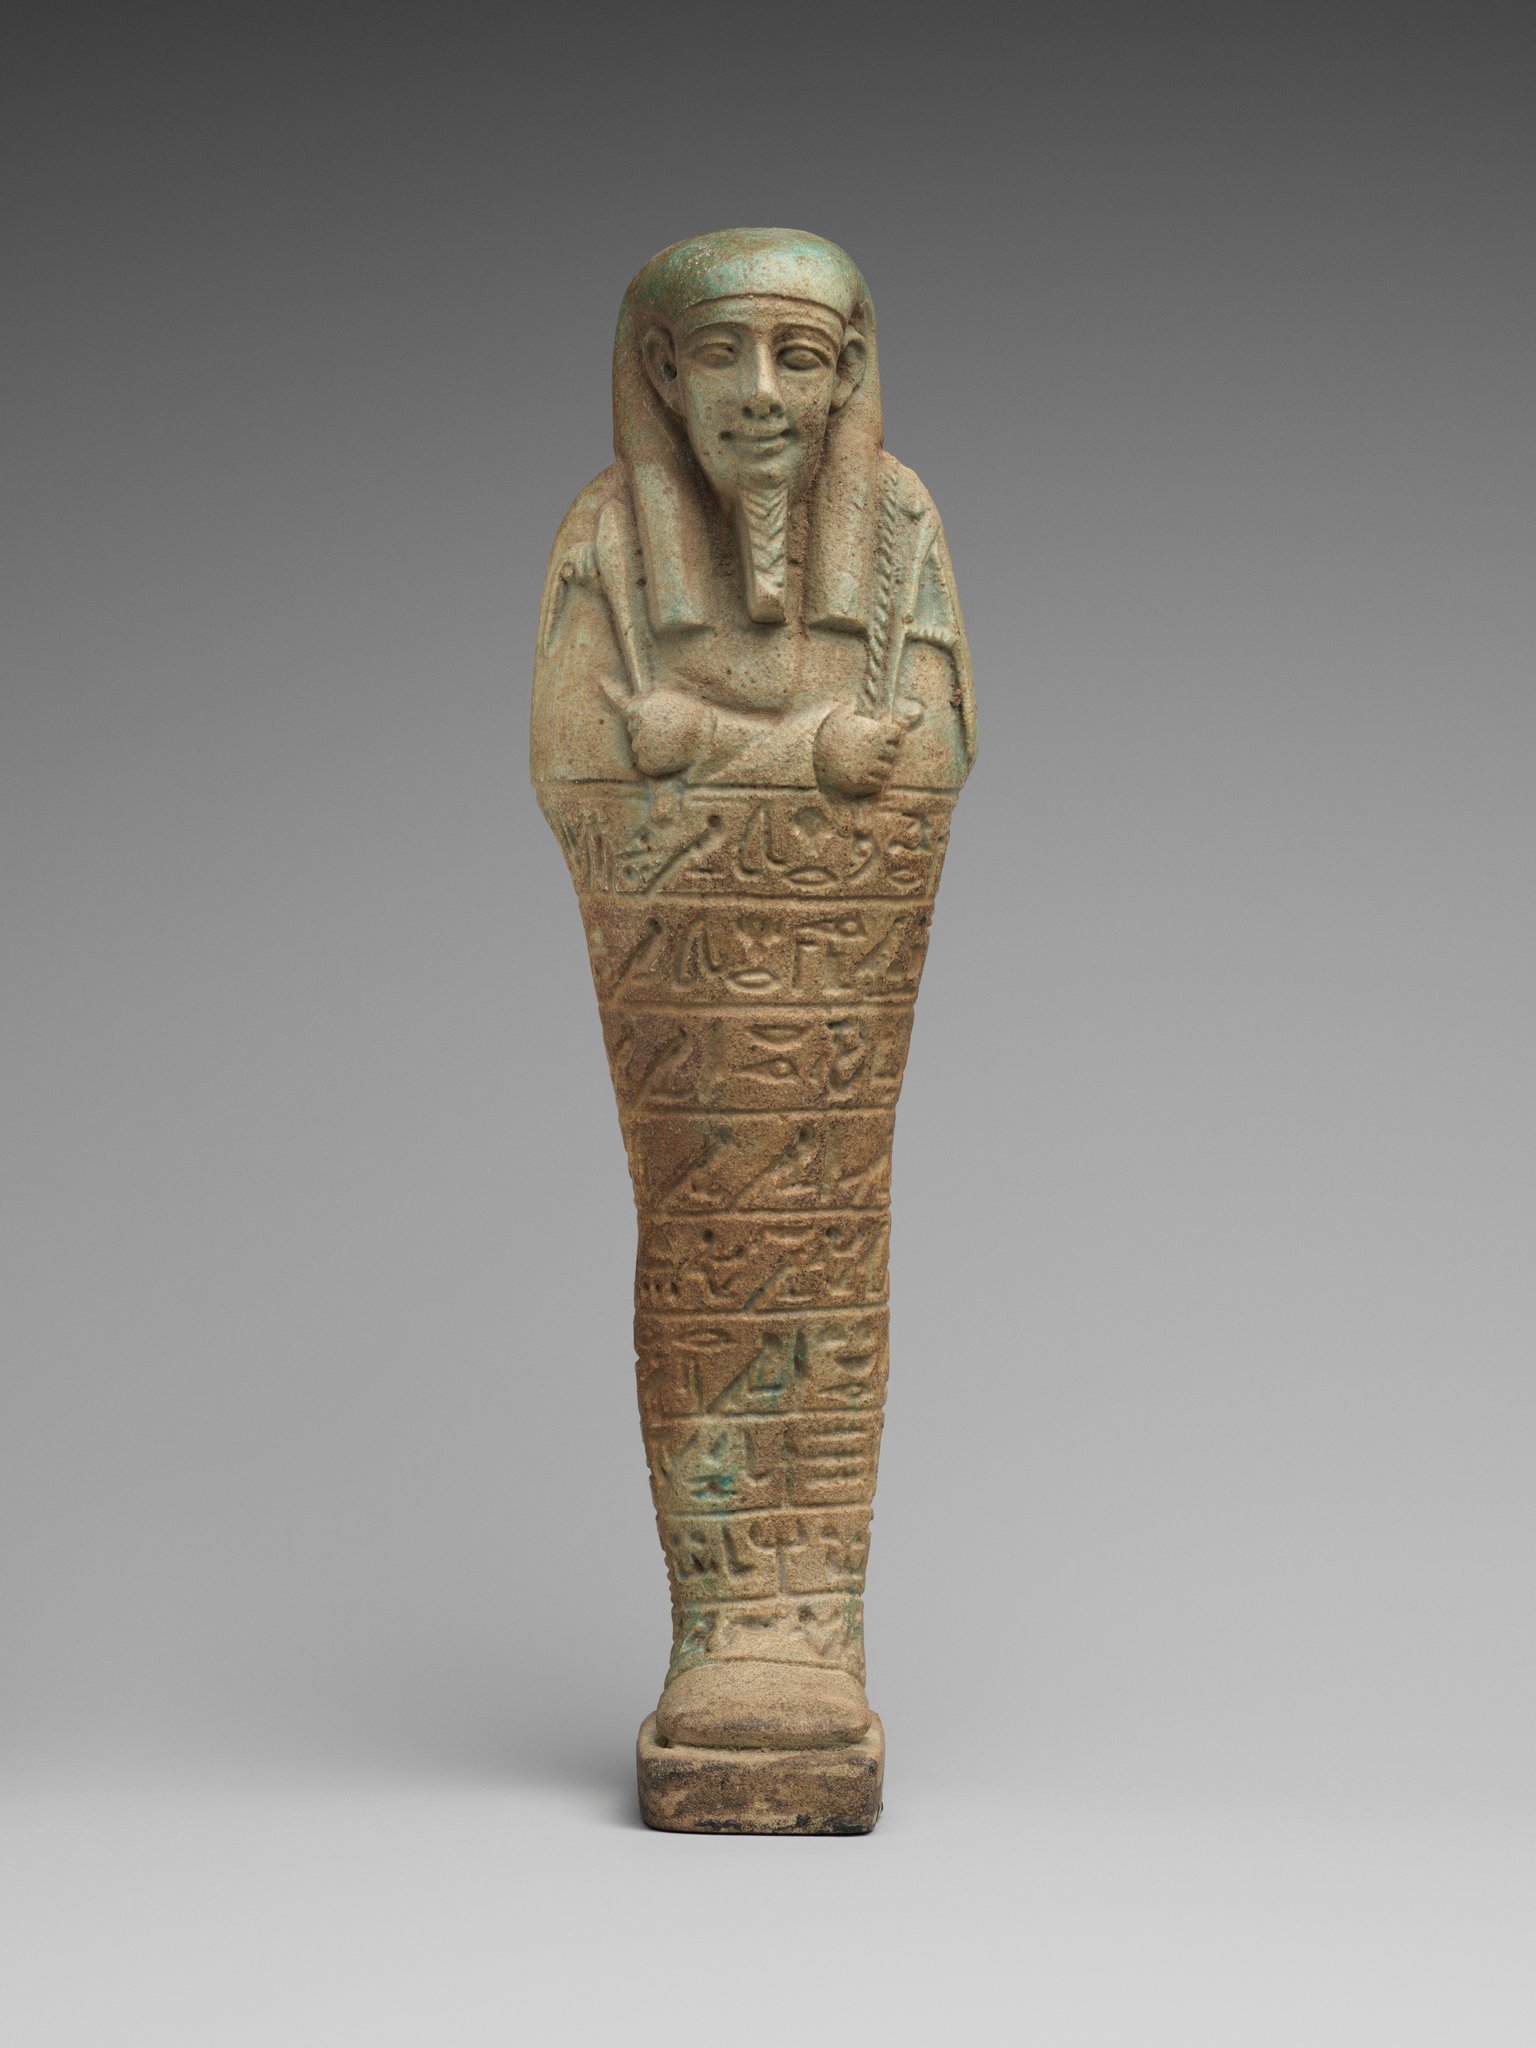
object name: shabti, priest hariuemhotep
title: Shabti of the Priest Hariuemhotep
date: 664-525 BCE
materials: faience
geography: egypt